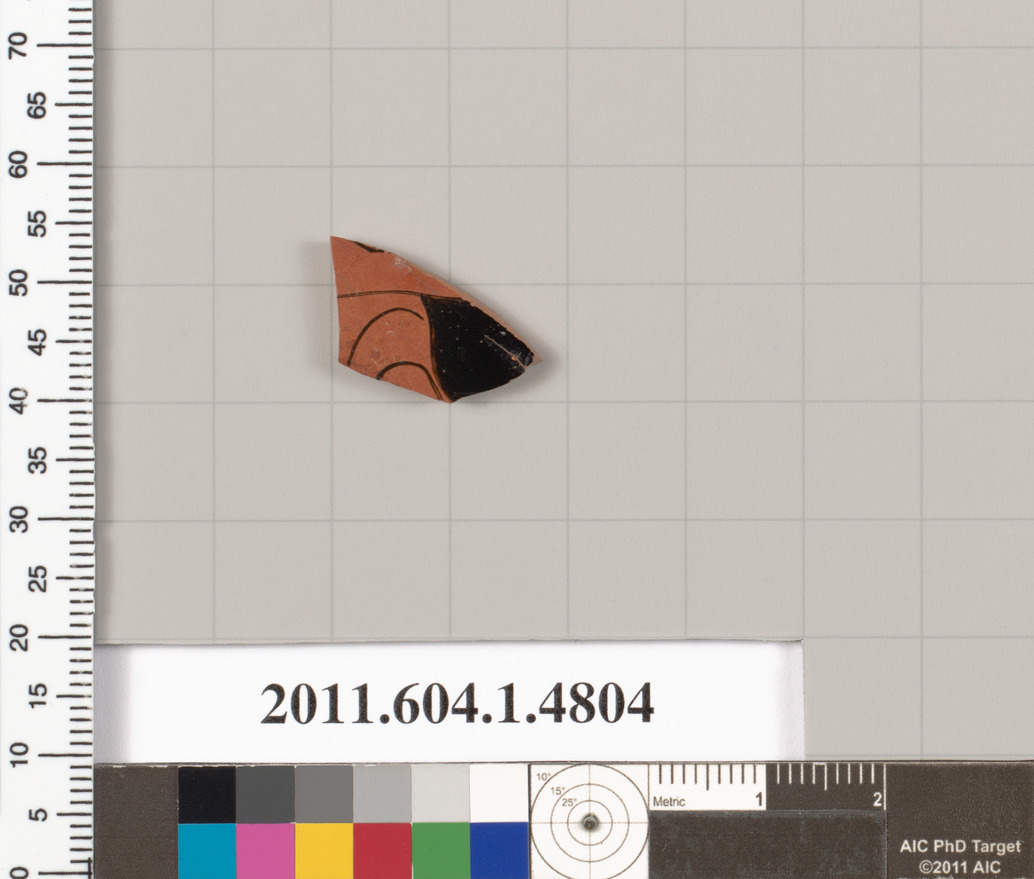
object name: kylix fragment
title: Terracotta fragment of a kylix (drinking cup)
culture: greek, attic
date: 475-451 BCE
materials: terracotta